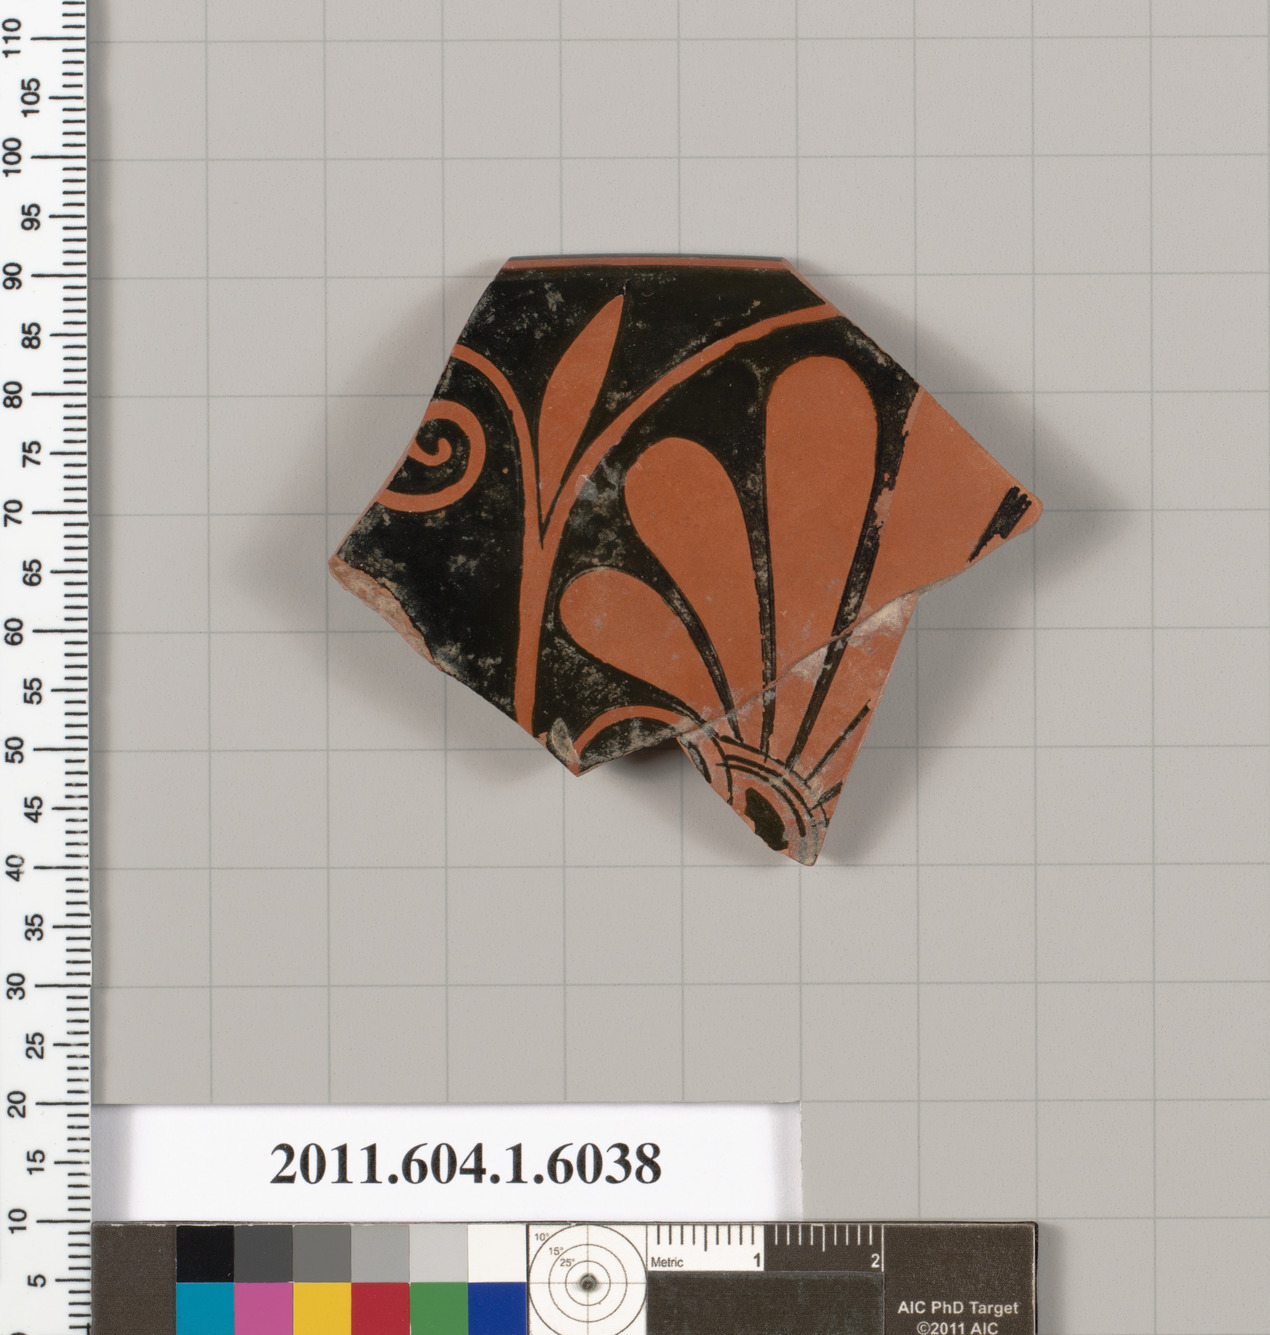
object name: kylix fragment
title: Terracotta rim fragment of a kylix (drinking cup)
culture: greek, attic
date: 510-500 BCE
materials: terracotta